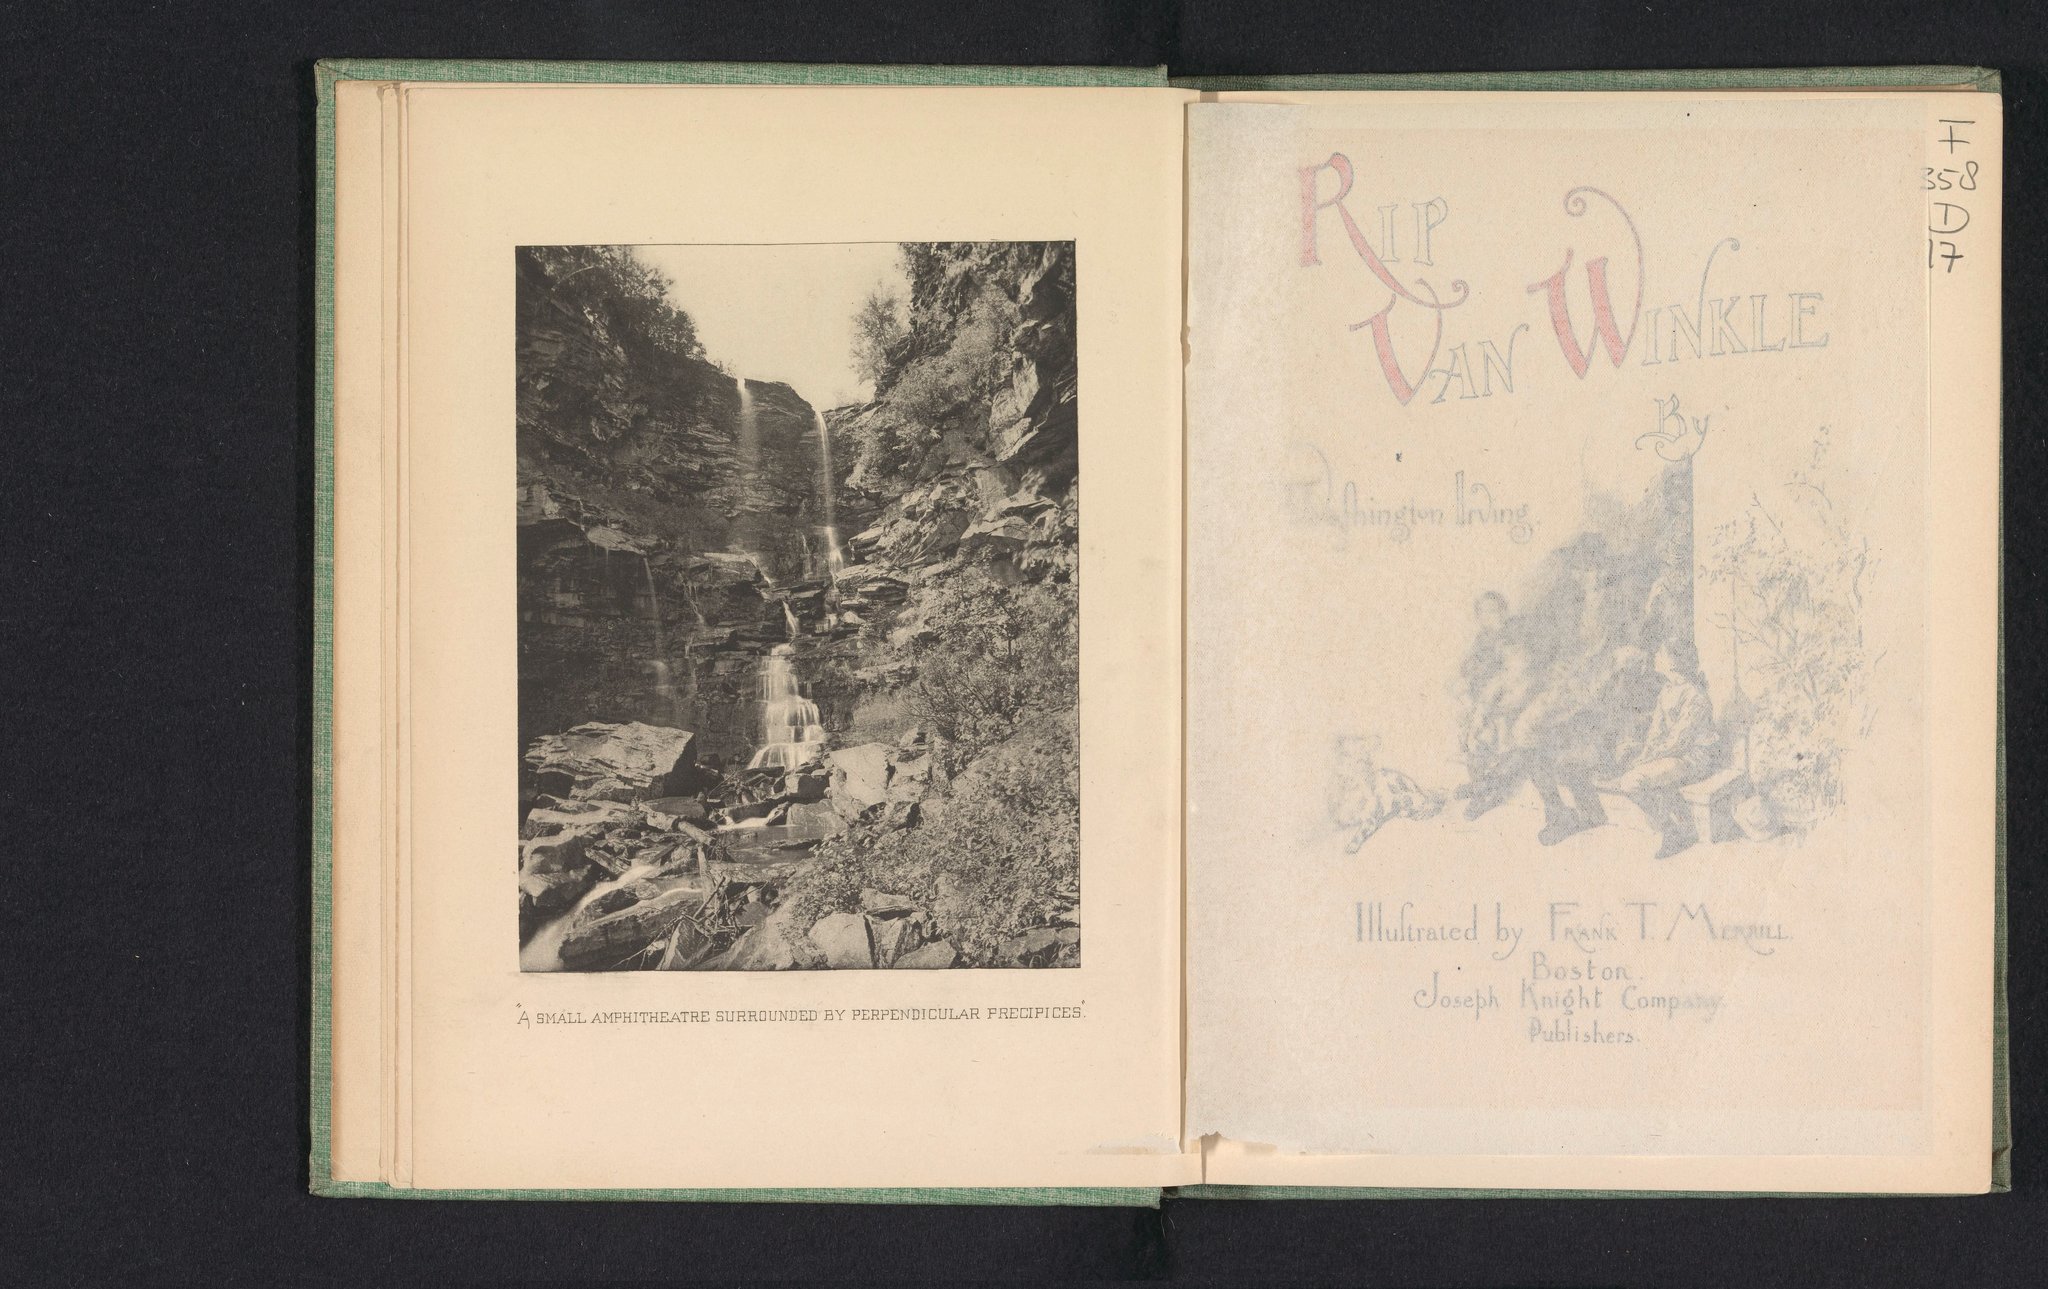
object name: photomechanical print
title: Gezicht op een waterval in het Catskillgebergte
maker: Anonymous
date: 1884-1894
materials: paper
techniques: photoaquatint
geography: catskill mountains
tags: waterfall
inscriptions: inscription: ‘“A small amphitheatre surrounded by perpendicular precipices.”’